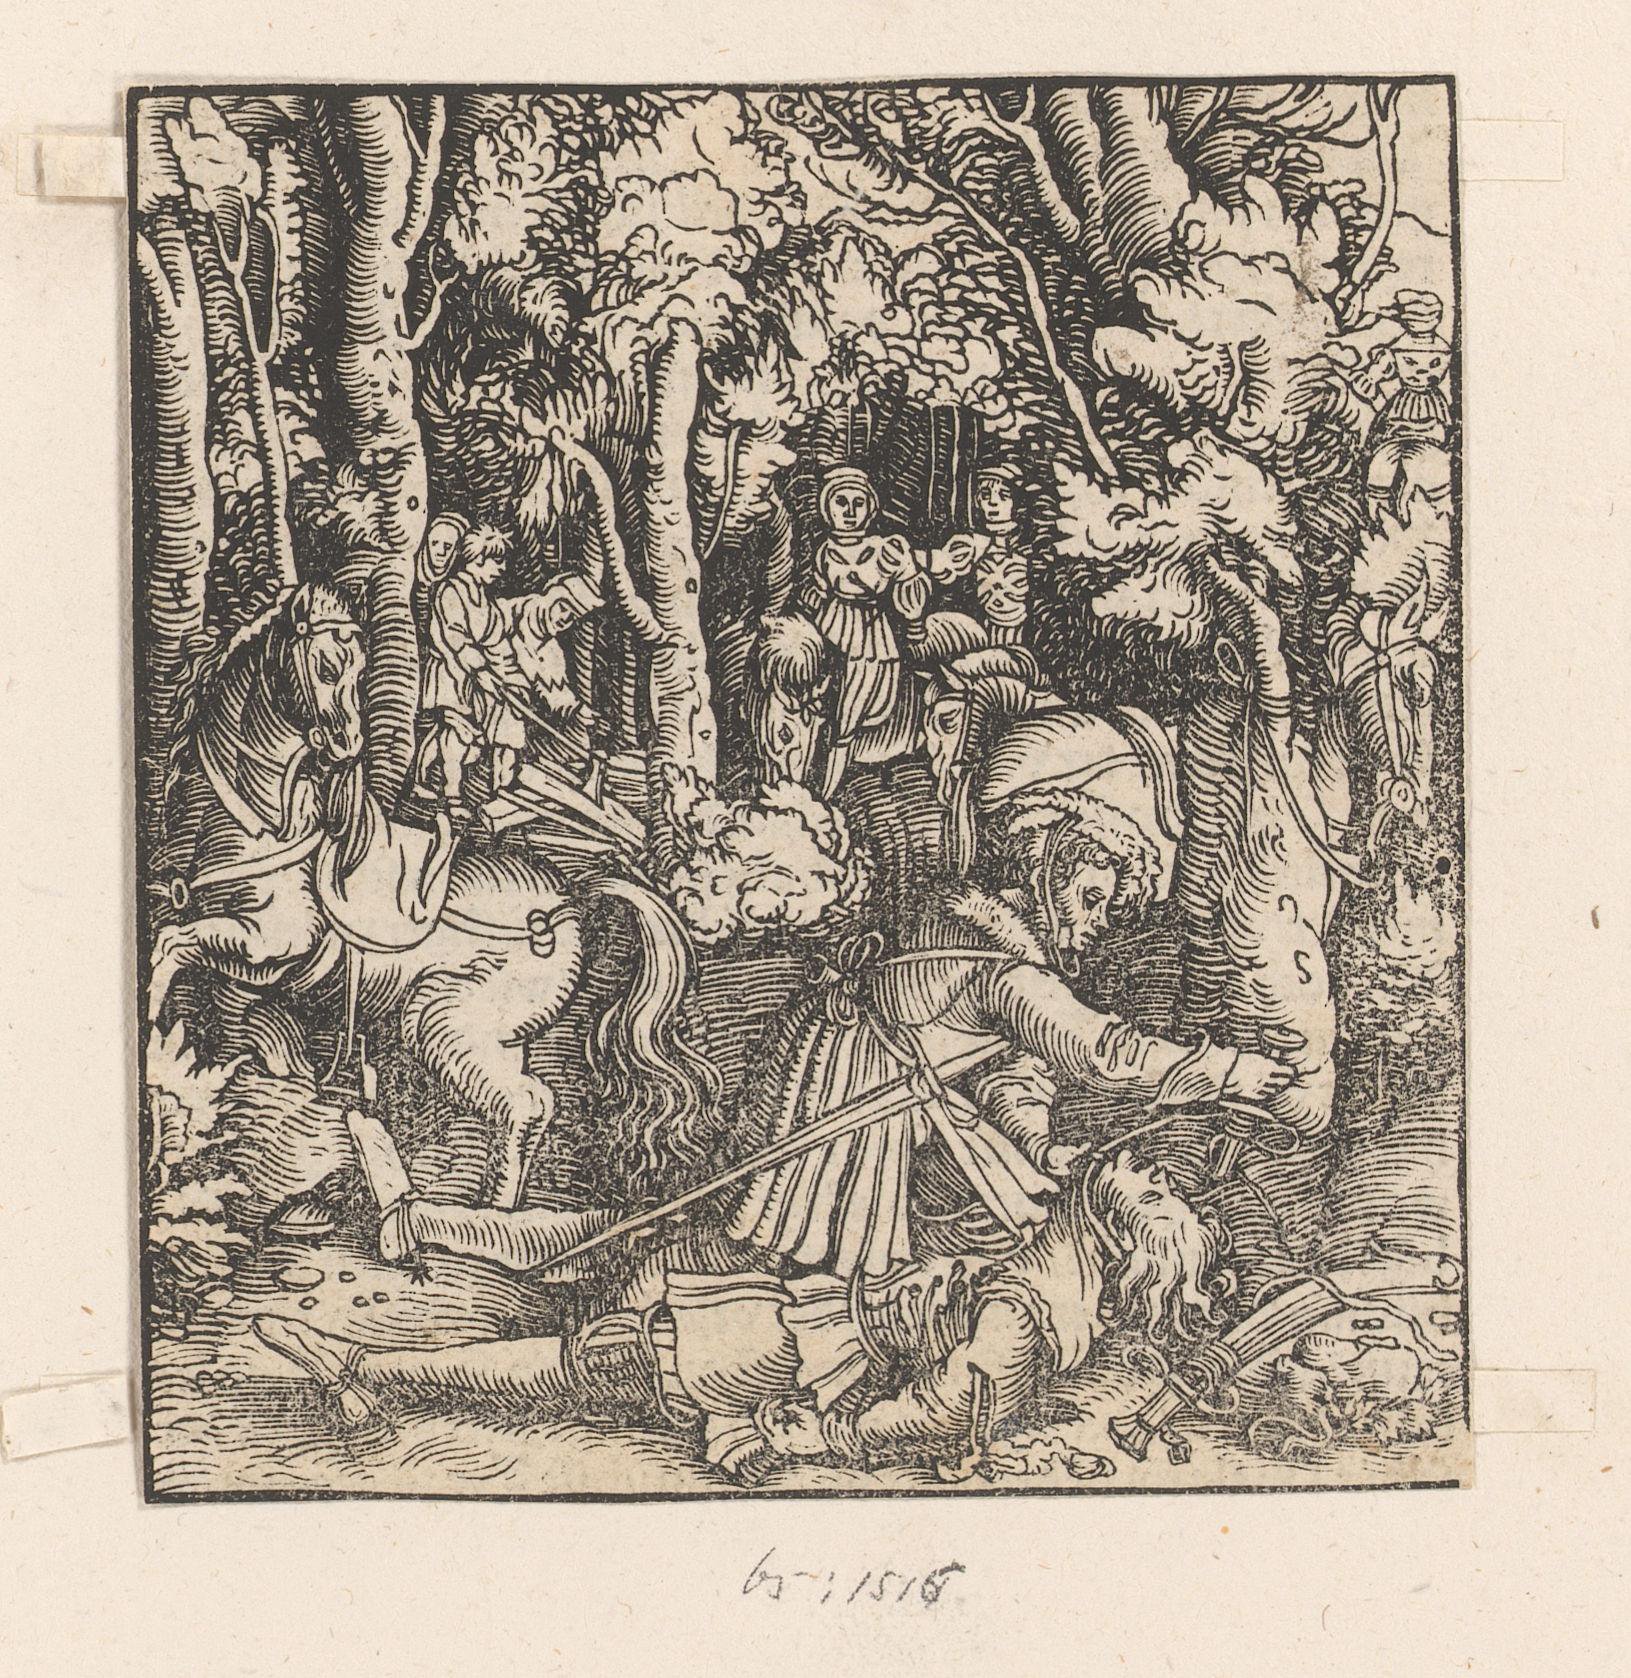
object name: print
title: Moord op Hans von Hutten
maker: Anonymous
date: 1517-1518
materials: paper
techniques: woodcut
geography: germany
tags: murder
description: De moord op Hans von Hutten door hertog Ulrich van Württemberg. Prent maakt deel uit van een album.